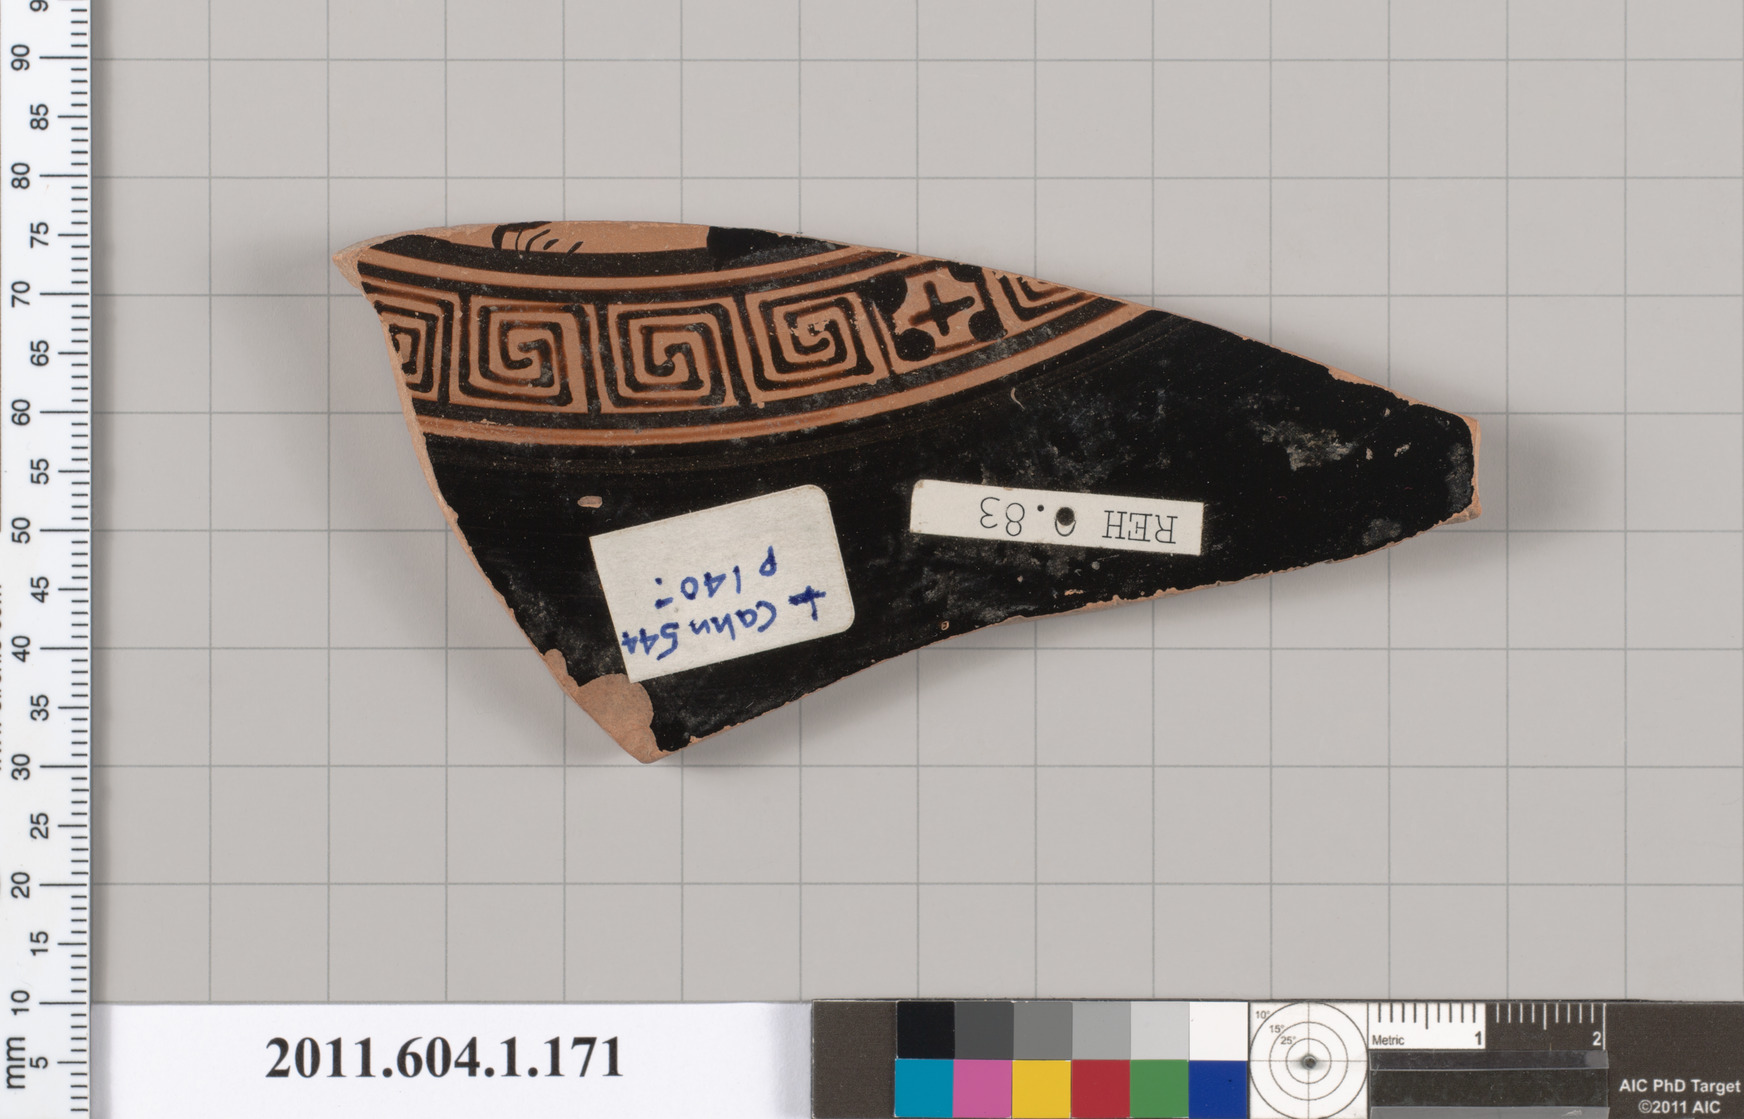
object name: kylix fragment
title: Terracotta fragment of a kylix (drinking cup)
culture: greek, attic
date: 470-450 BCE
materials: terracotta